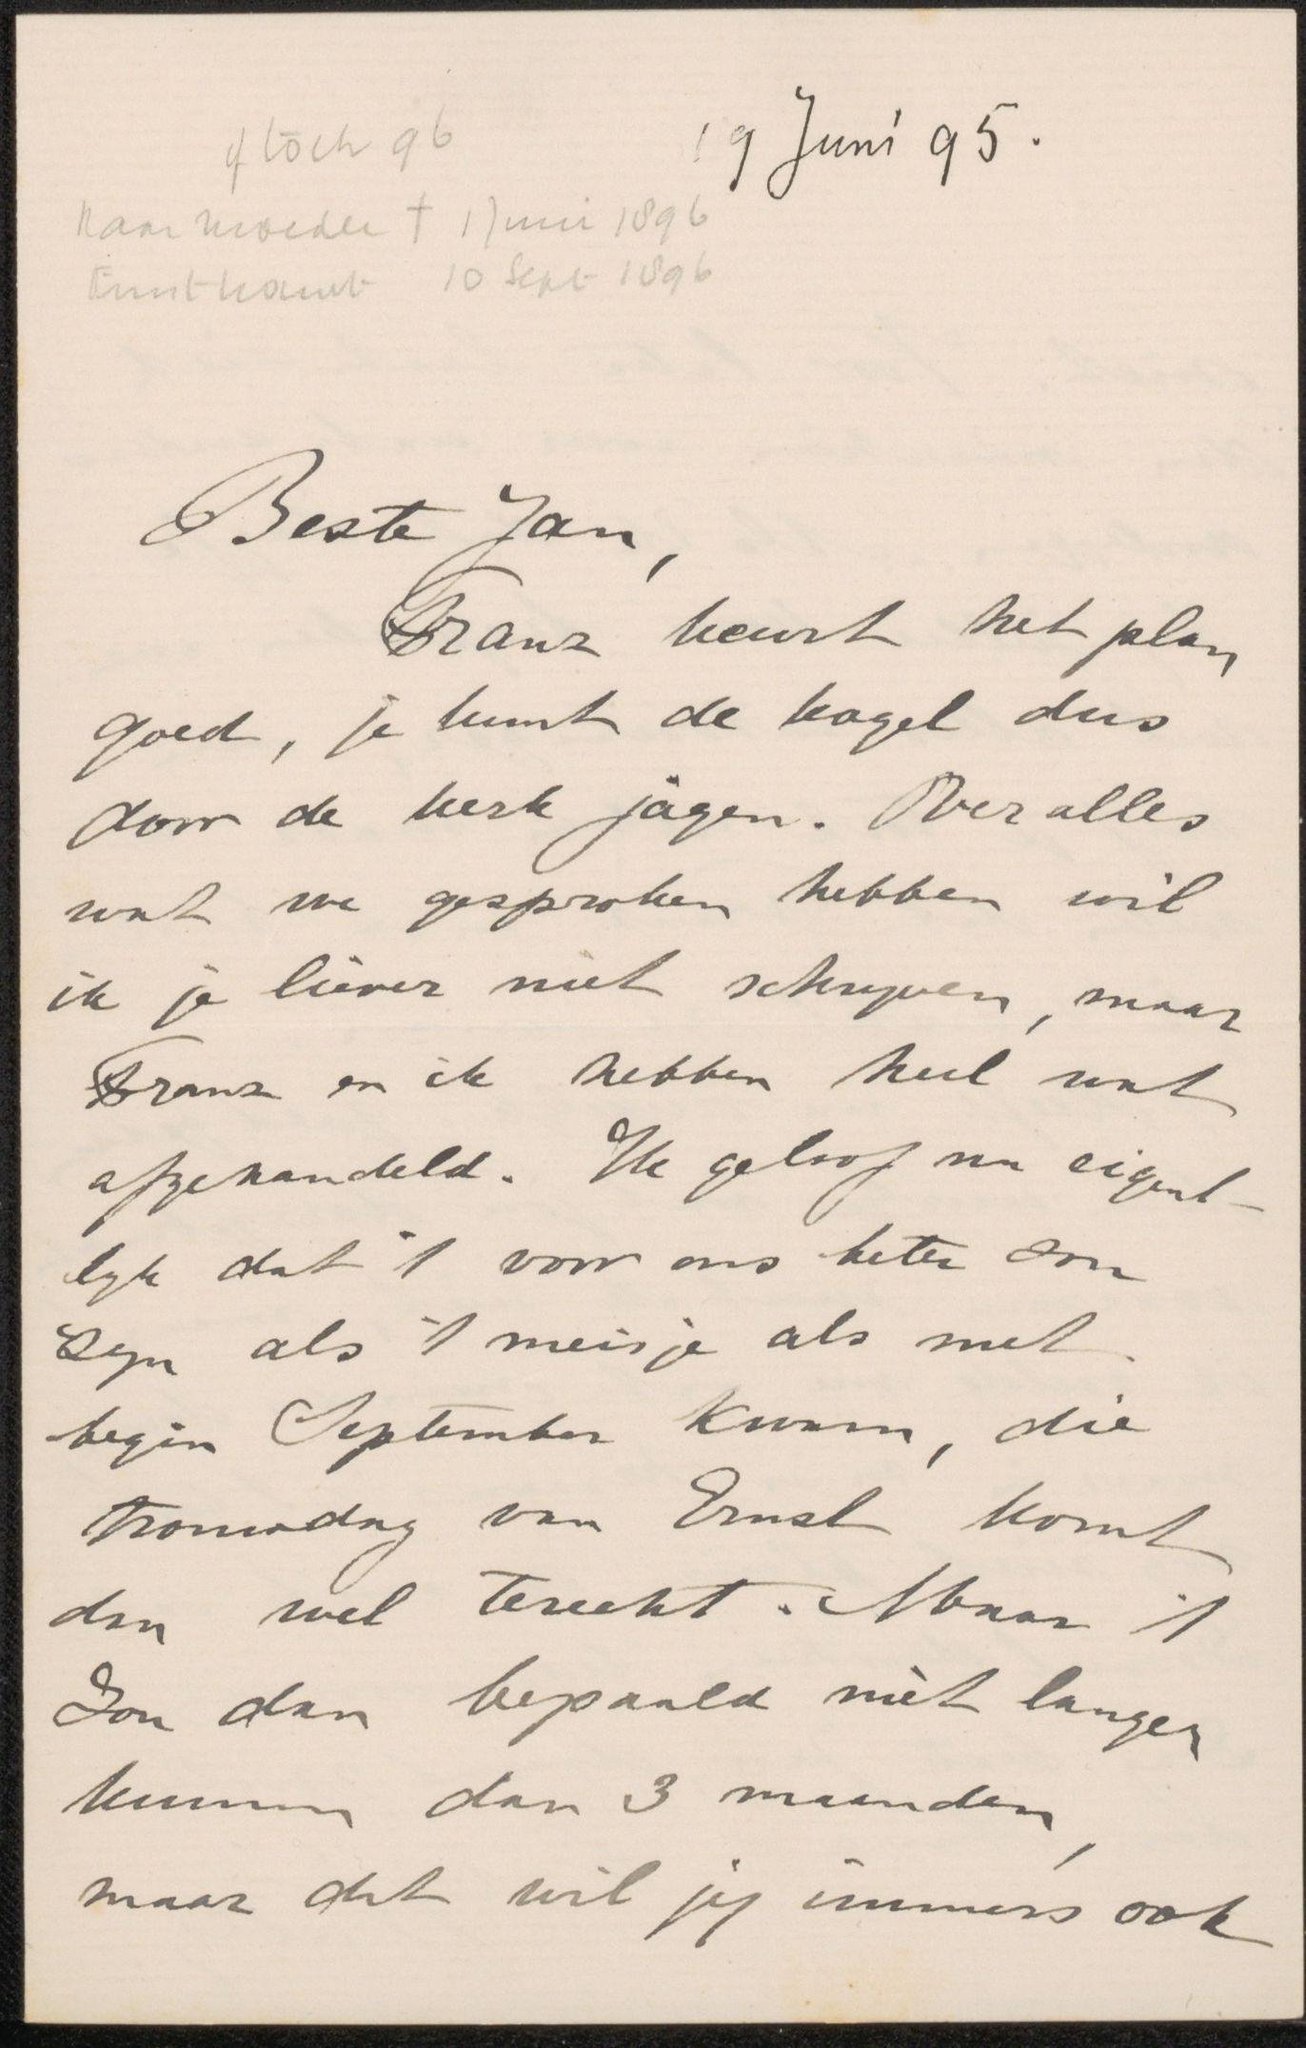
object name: letter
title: Brief aan Jan Veth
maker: wally moes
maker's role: draughtsman, print maker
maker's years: 1856-1918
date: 1874-1918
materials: ink, paper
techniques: pen, writing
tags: dordrecht, painter, designer, jan veth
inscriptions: collector's mark: ‘RPK’